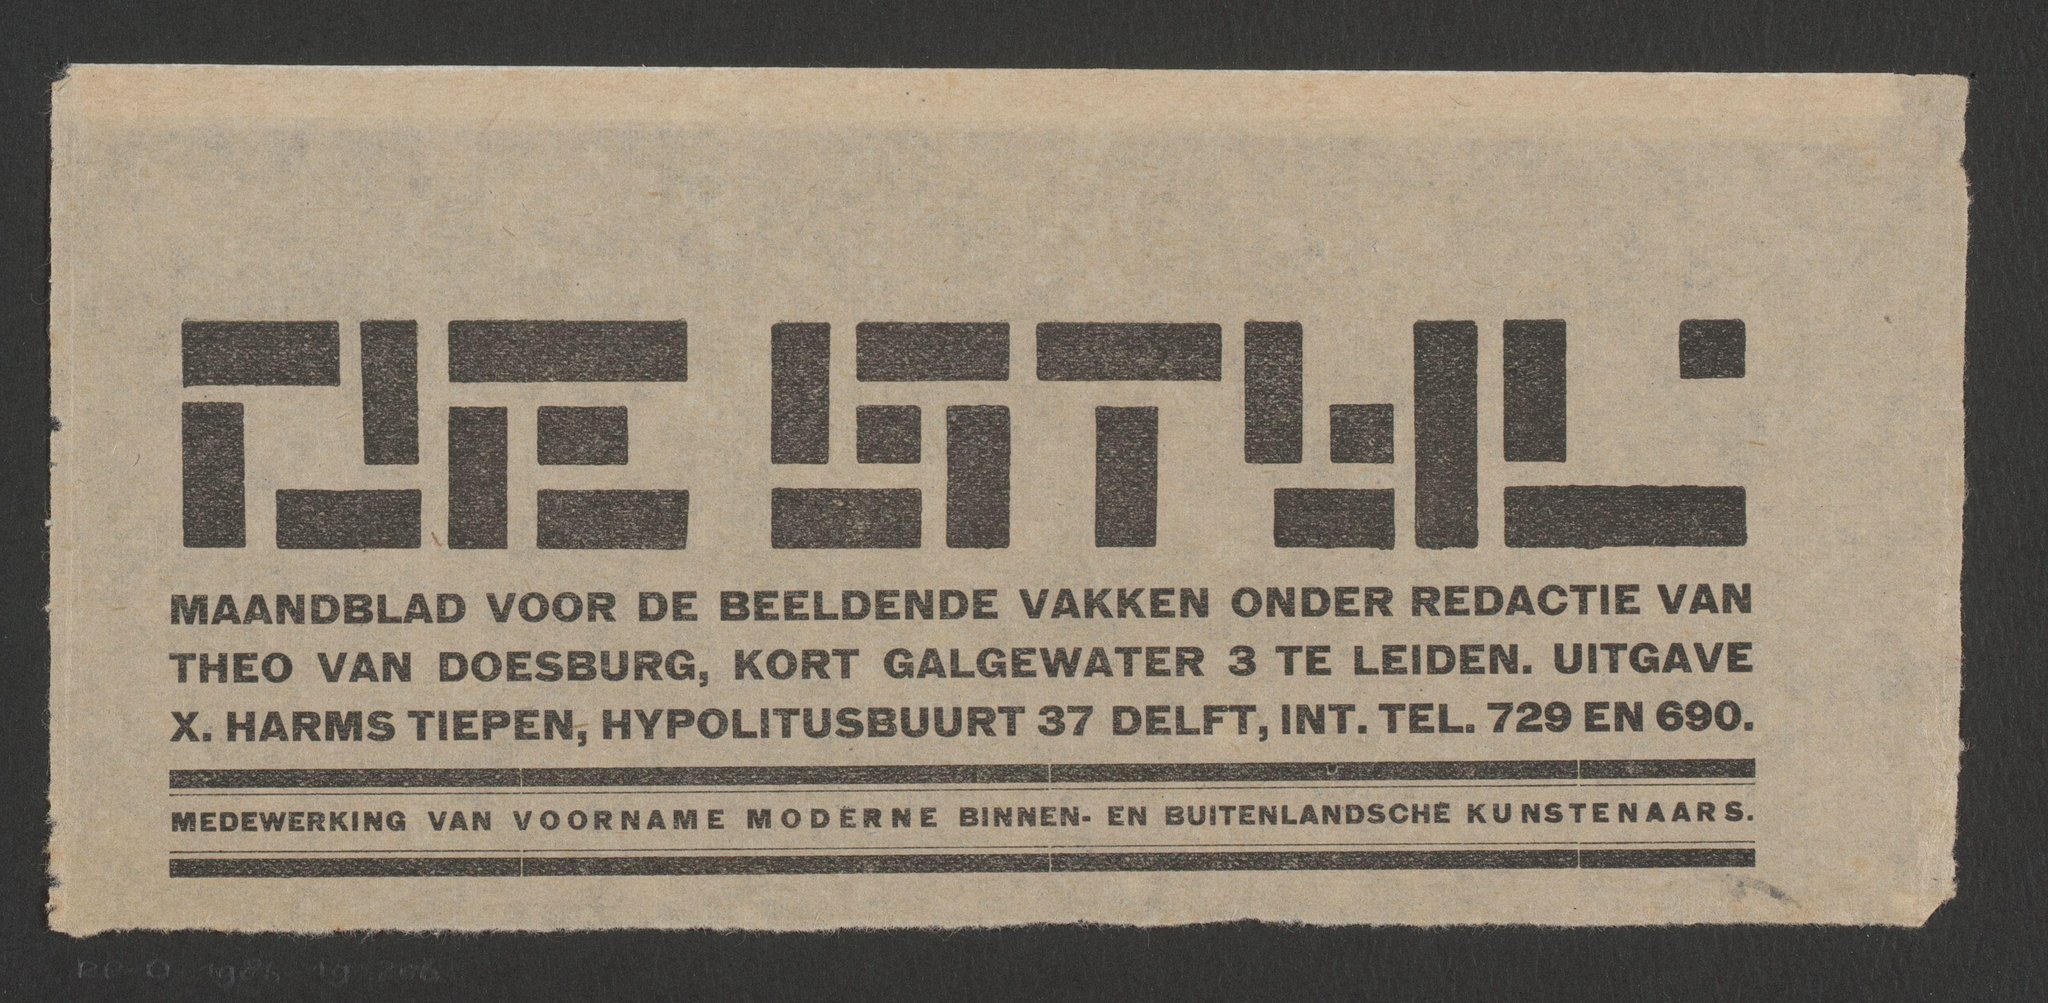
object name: print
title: Titelhoofd voor De Stijl: Maandblad voor de beeldende vakken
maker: Anonymous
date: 1917-1928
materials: paper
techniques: relief print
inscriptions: collector's mark: ‘R:MVS.’